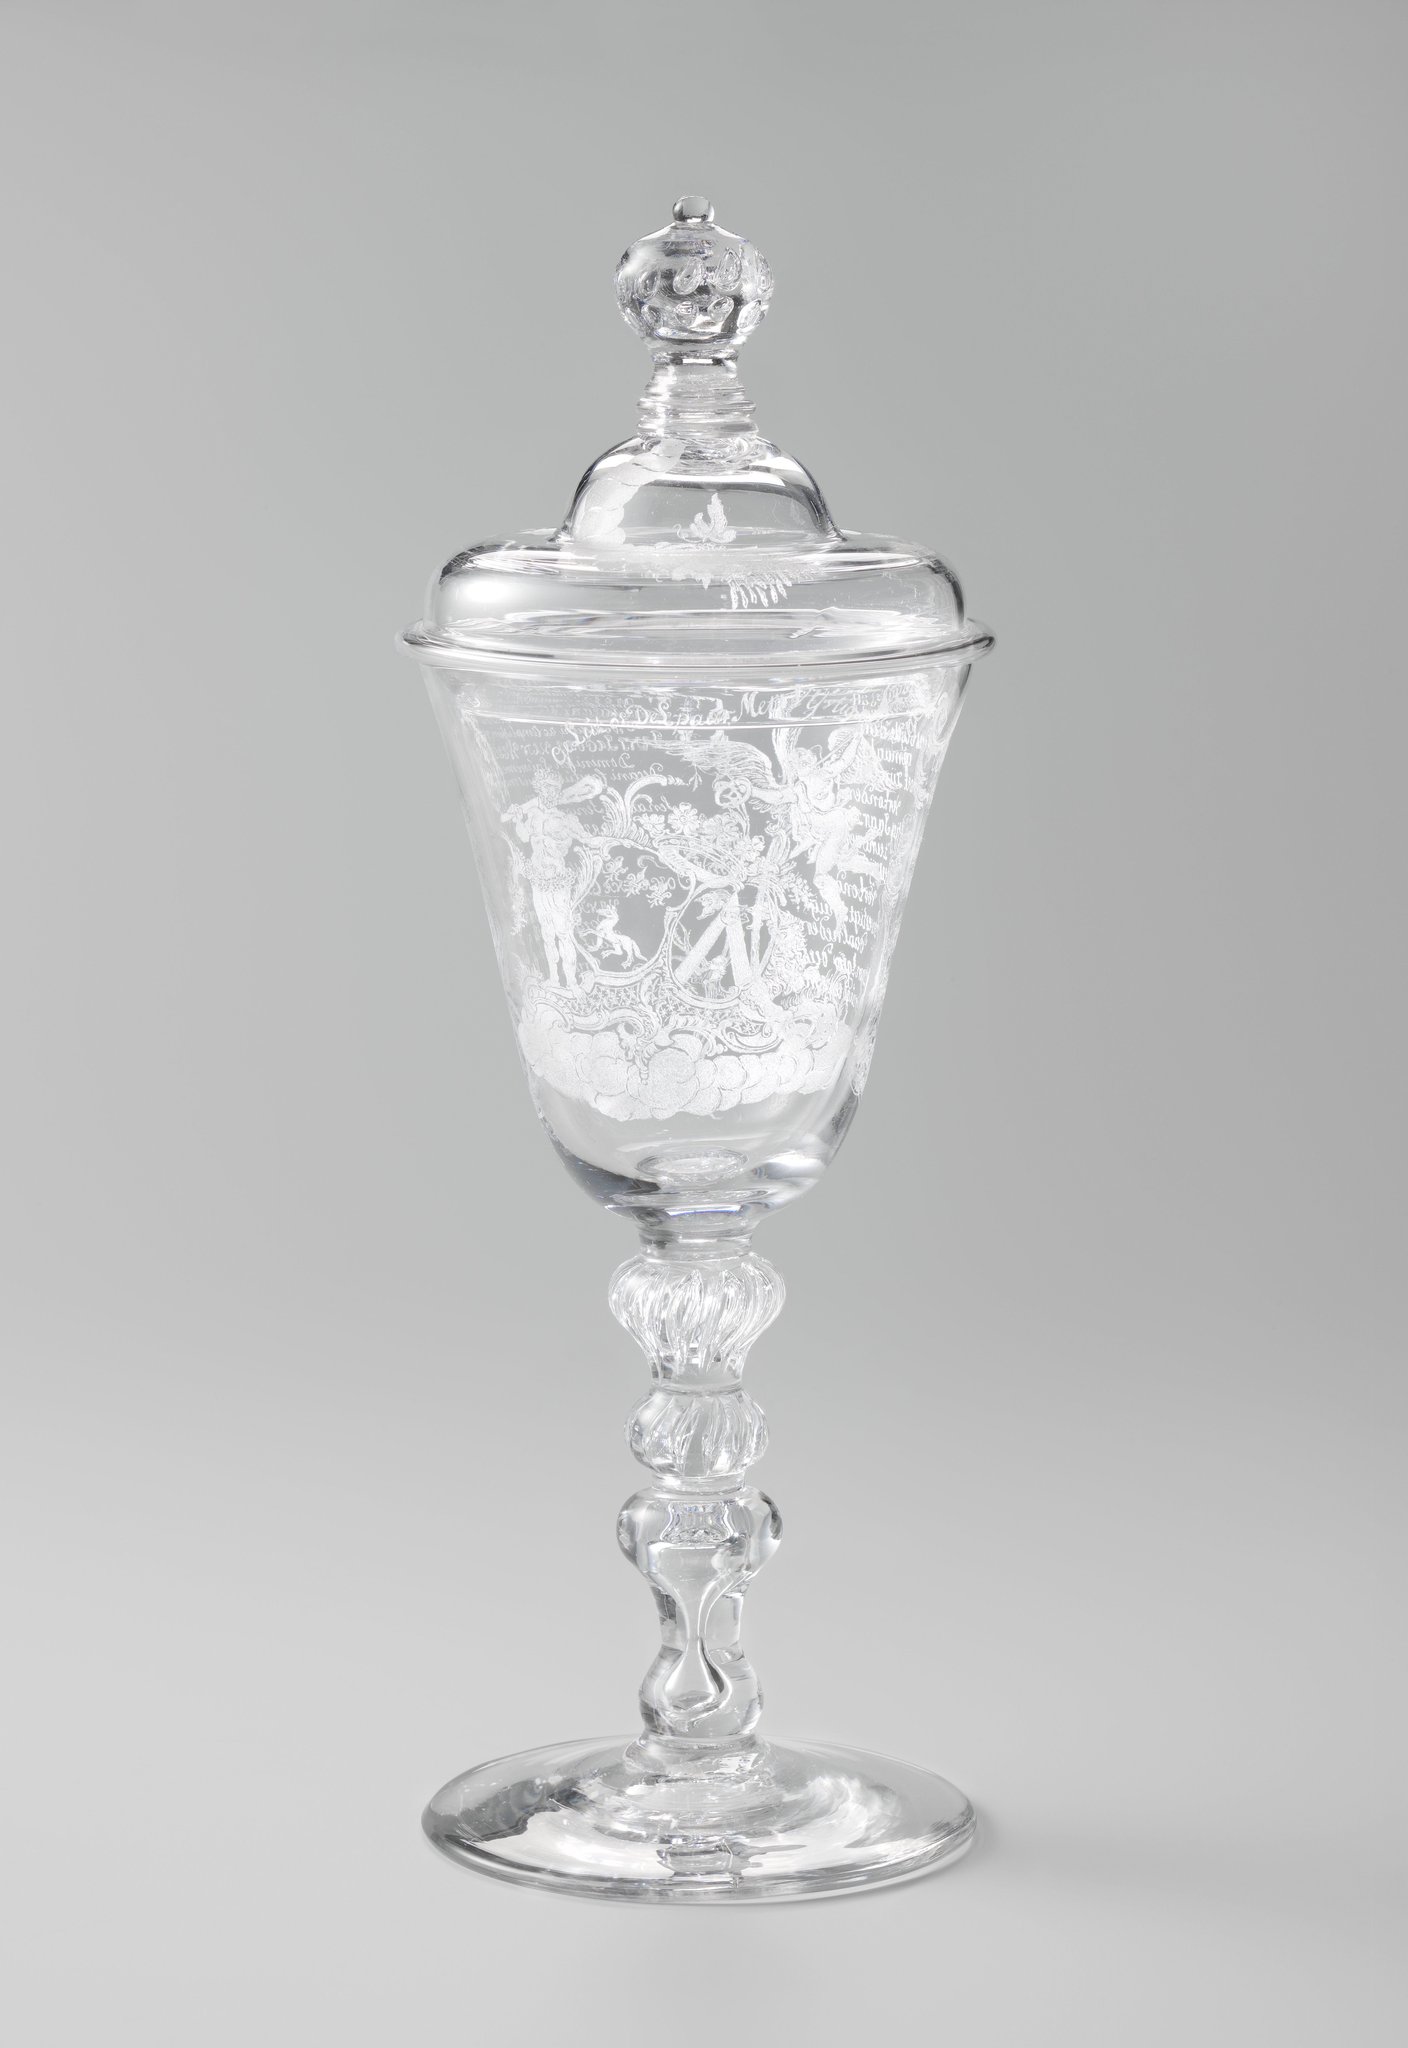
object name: lid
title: Pair of marriage goblets with lids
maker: Anonymous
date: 1759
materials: glass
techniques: diamond point engraving, glassblowing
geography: northern netherlands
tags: utrecht, serpent ouroboros, fame; 'fama', 'fama buona', 'fama chiara' (ripa), weapons for striking a blow: club, armorial bearing, heraldry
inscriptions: inscription: ‘Geluk ô Edel paar met’t Vyftigst Huwelijk Jaar’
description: These goblets commemorate the fiftieth anniversary of Jan Jacob van Westrenen and Johanna Catharina Mamuchet van Houdringe. The arms were executed with a diamond-point stylus, a small diamond chip in a holder used to incise the glass. This technique was common in the Netherlands in the 17th century. Translation of inscription A: Best wishes and good cheer oh Noble couple on your Fiftieth Wedding Year. Translation of inscription B: Despite the burden of so many years,